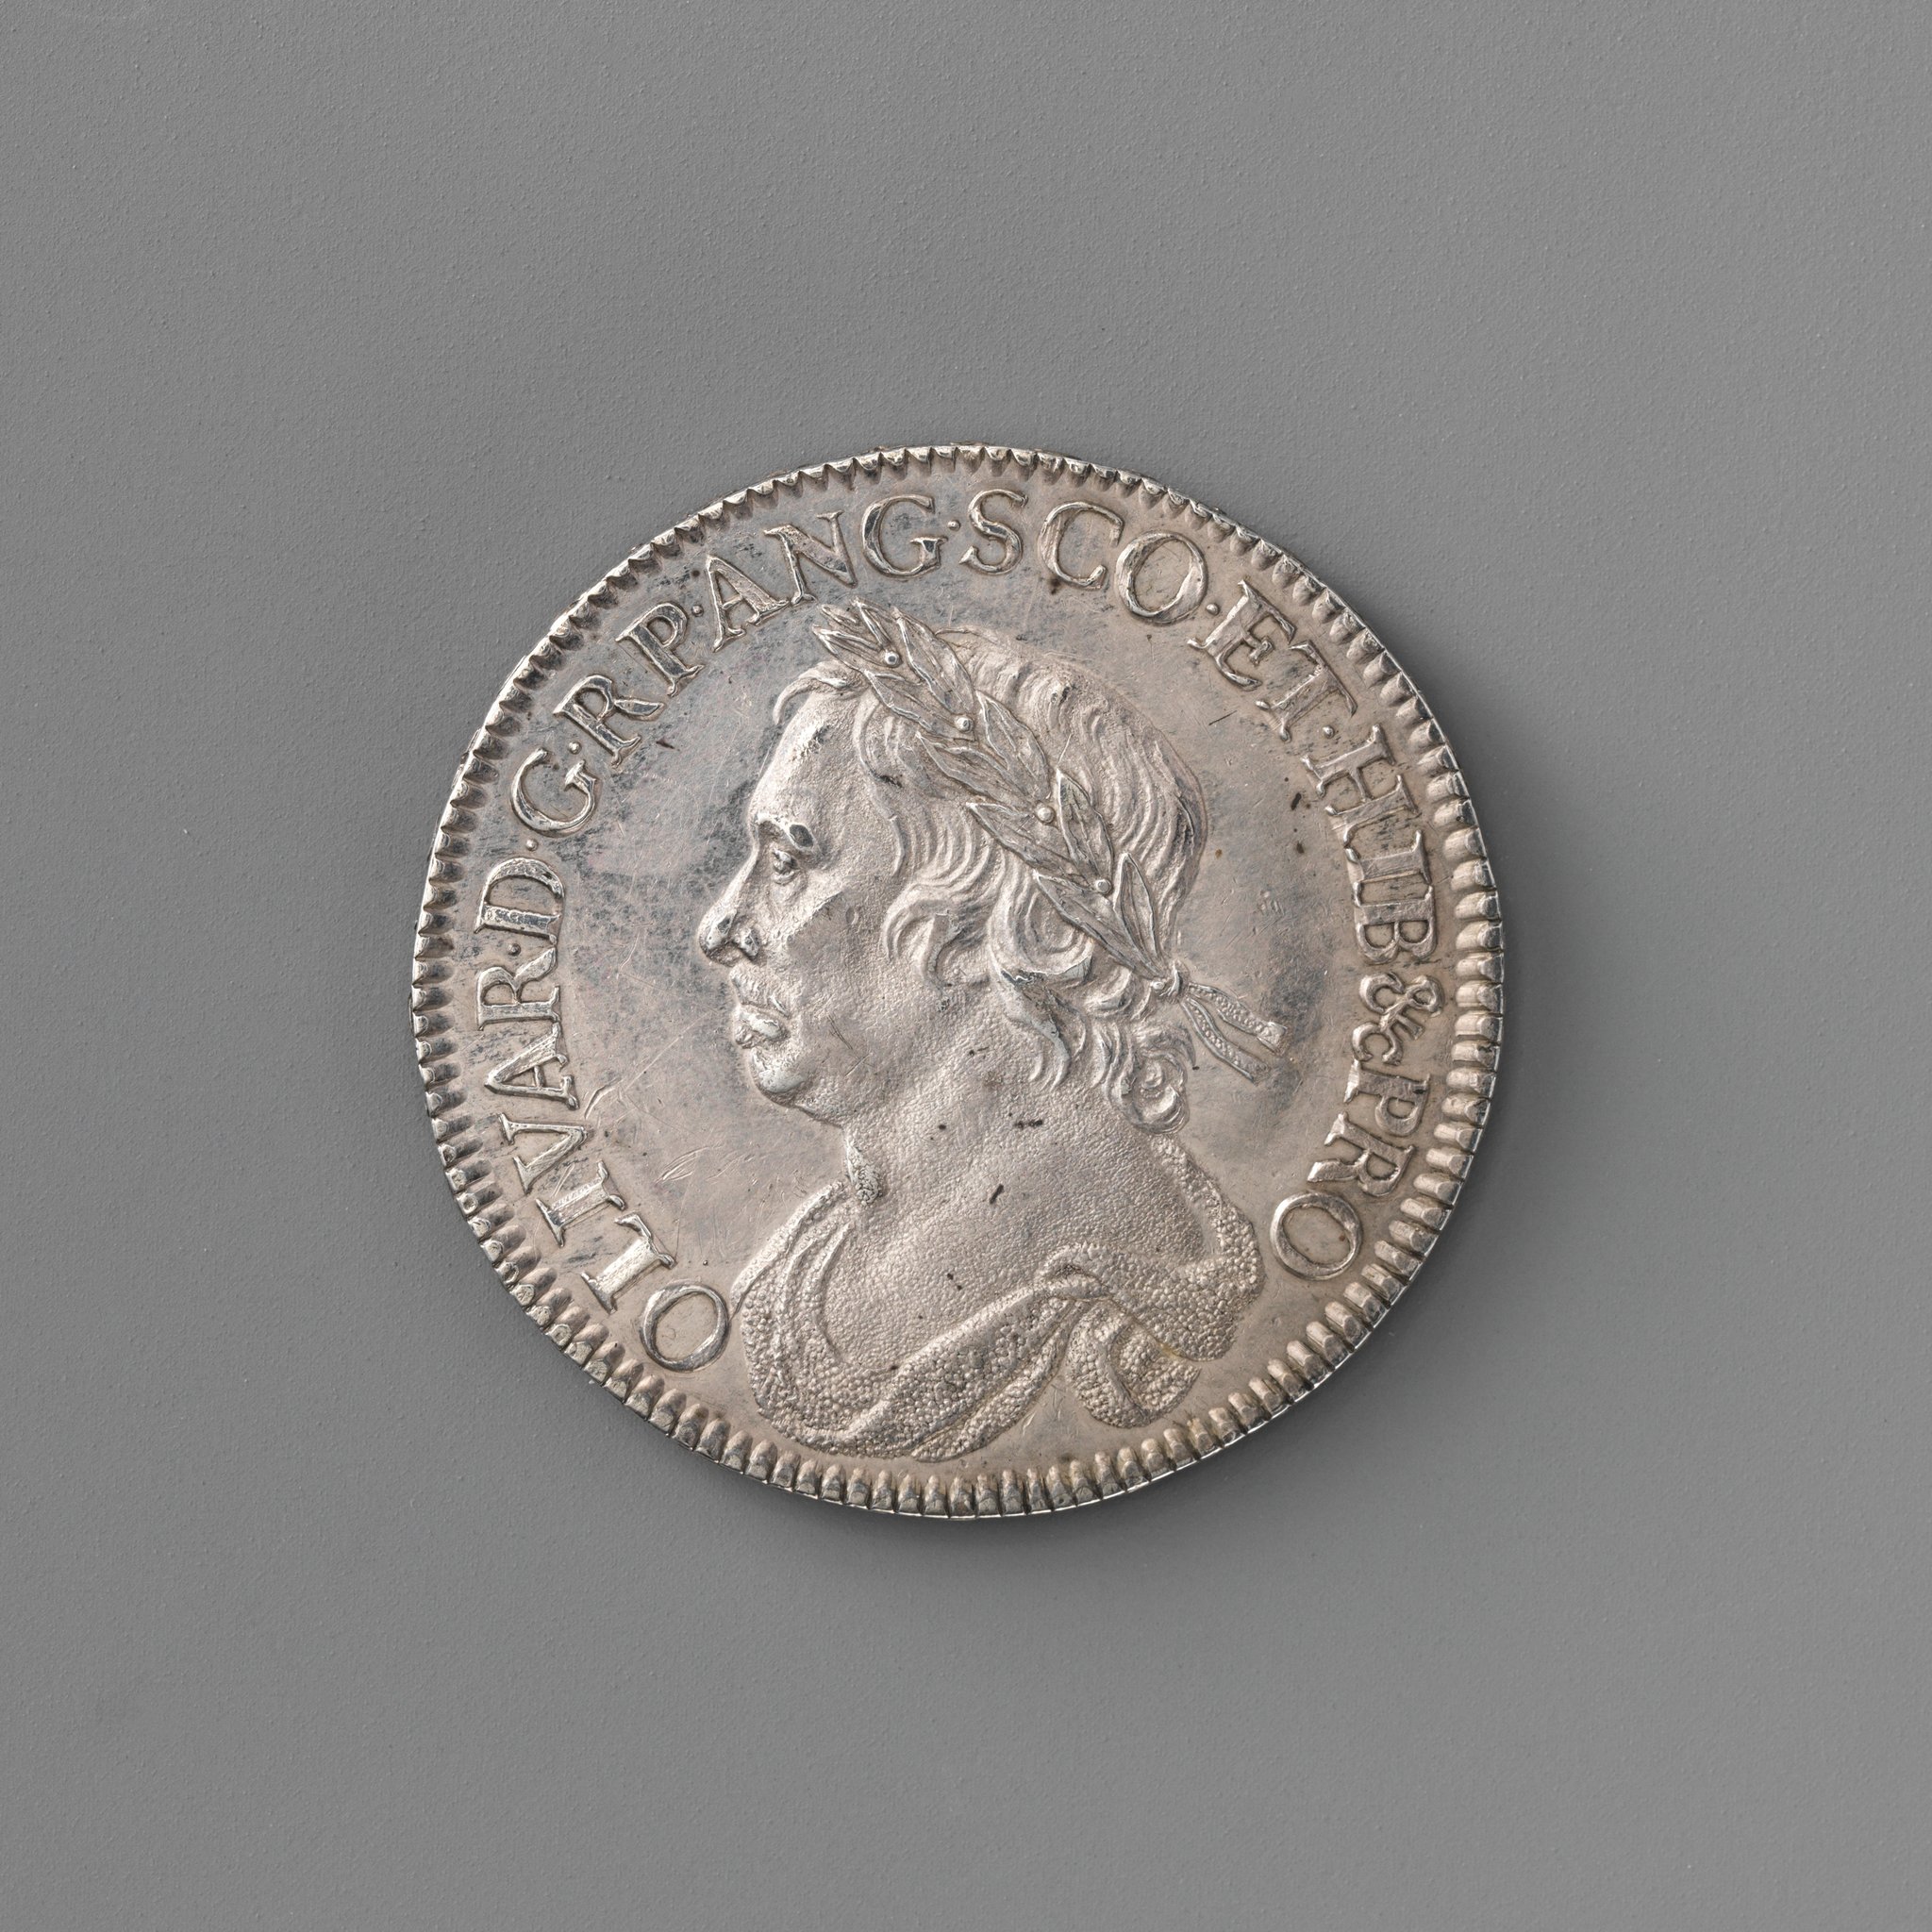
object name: half crown coin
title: Oliver Cromwell (Protector 1653–58)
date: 1658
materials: silver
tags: men,profiles,coins,coat of arms